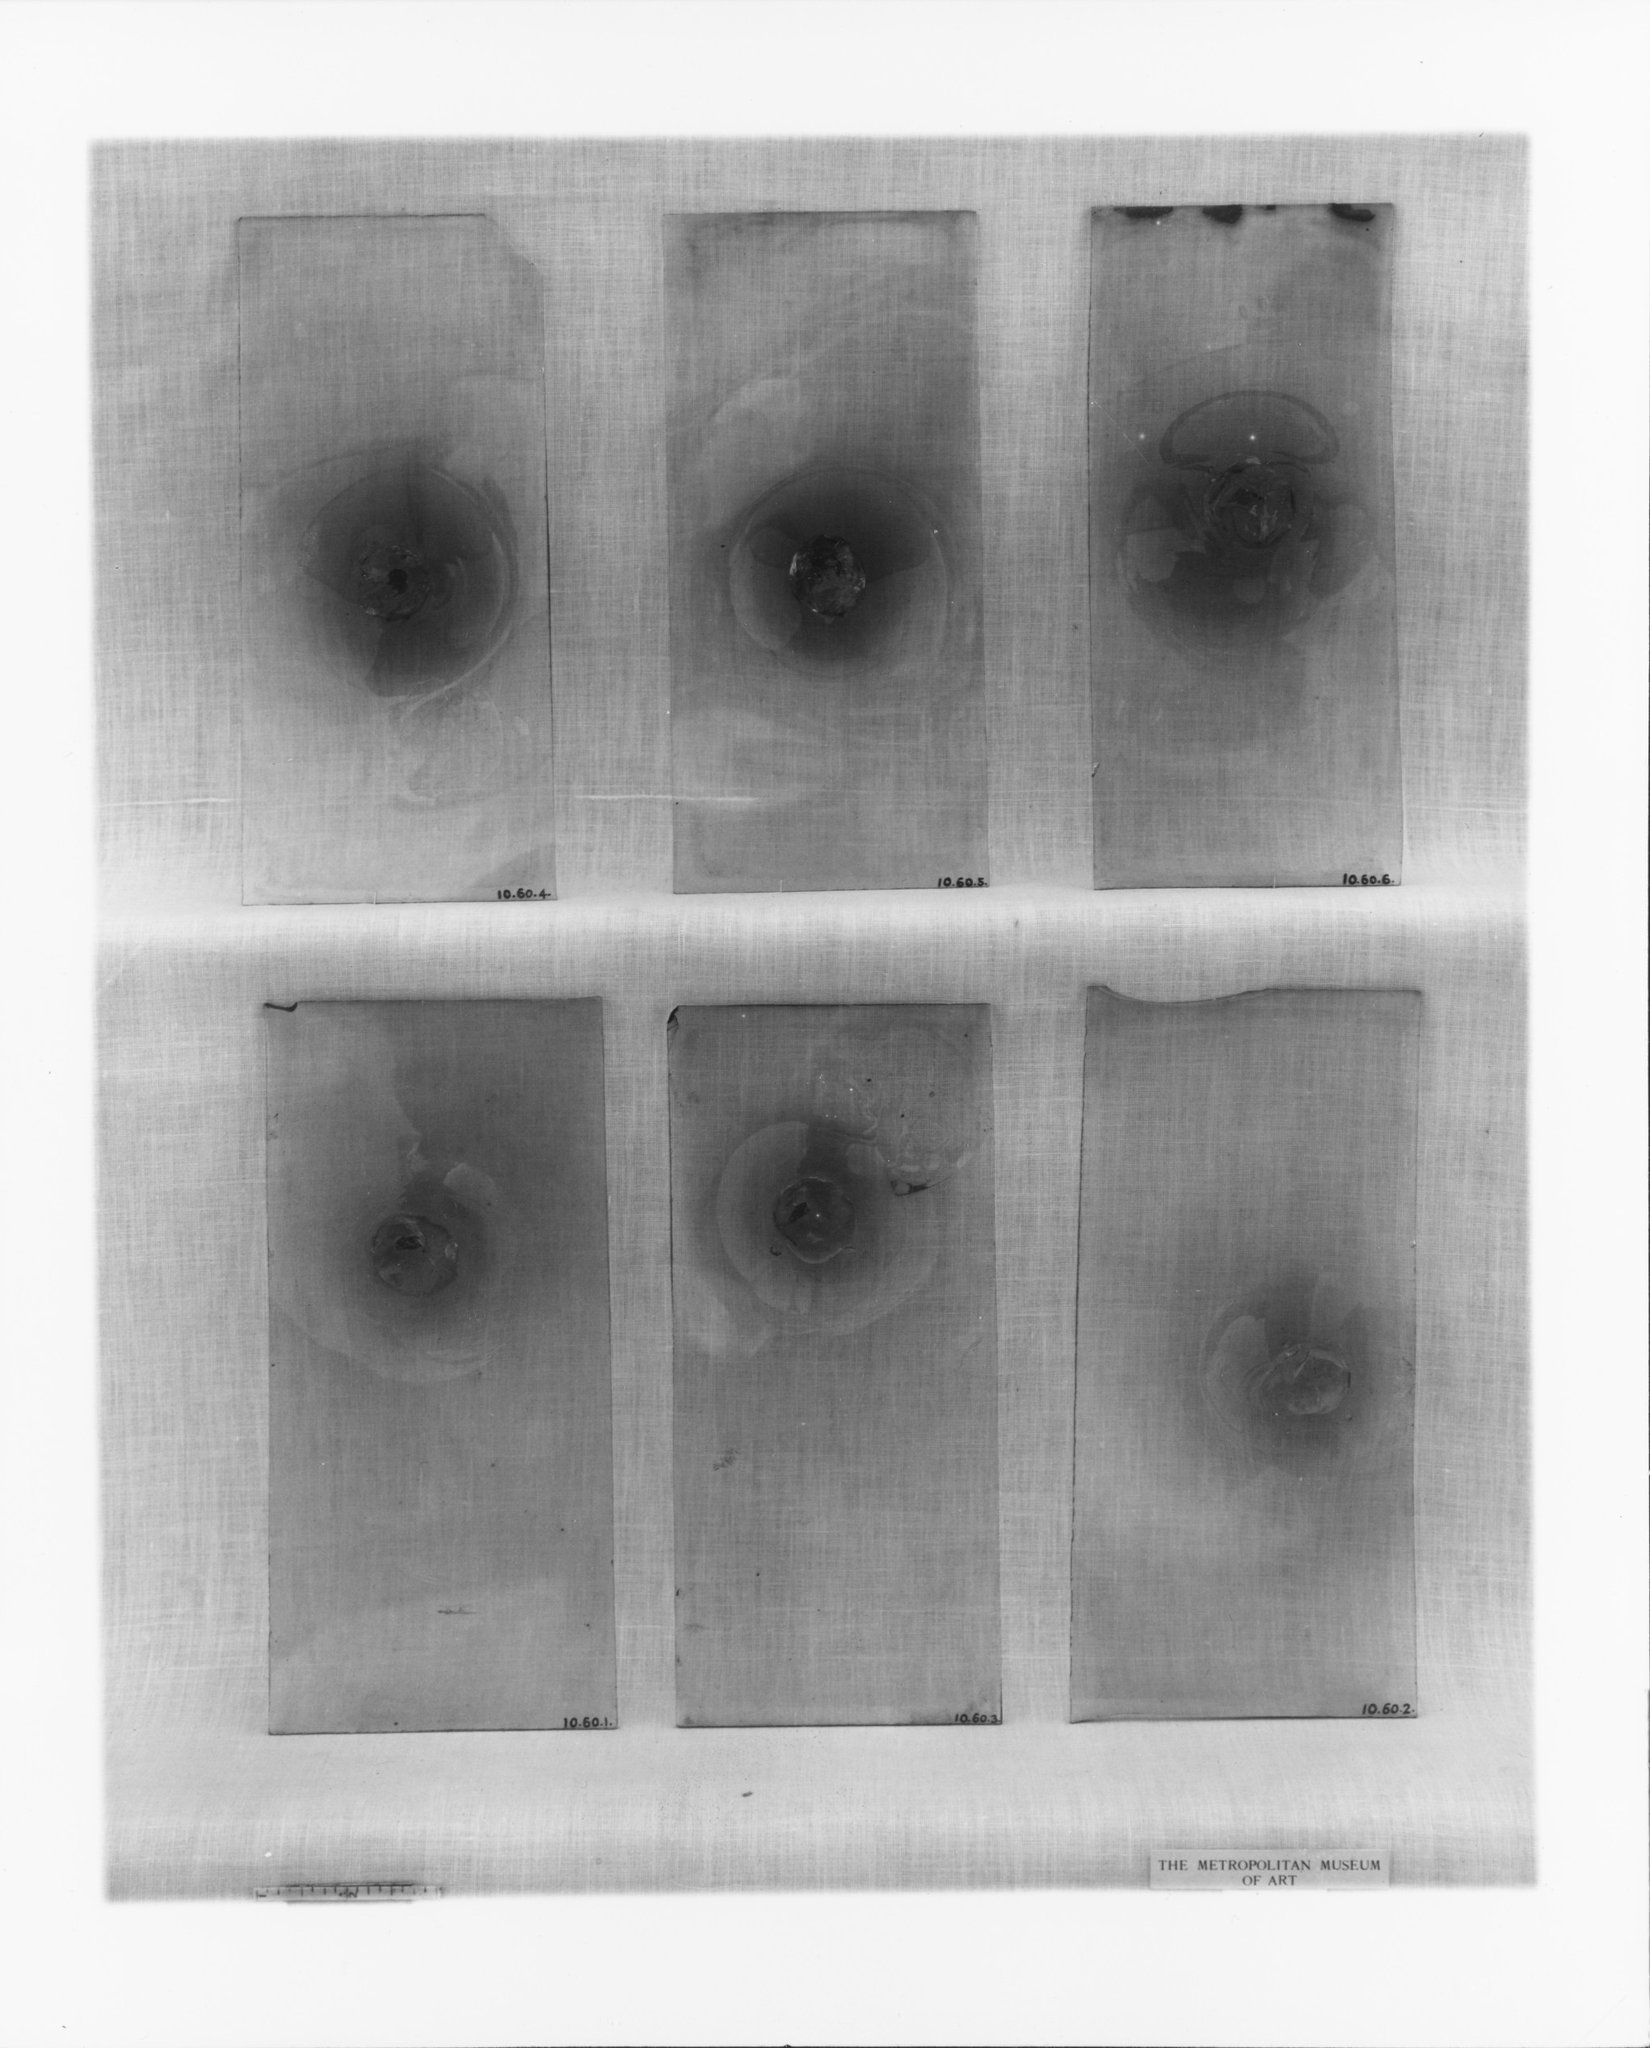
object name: windowpane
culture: american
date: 1701-1800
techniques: glassblowing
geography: united states